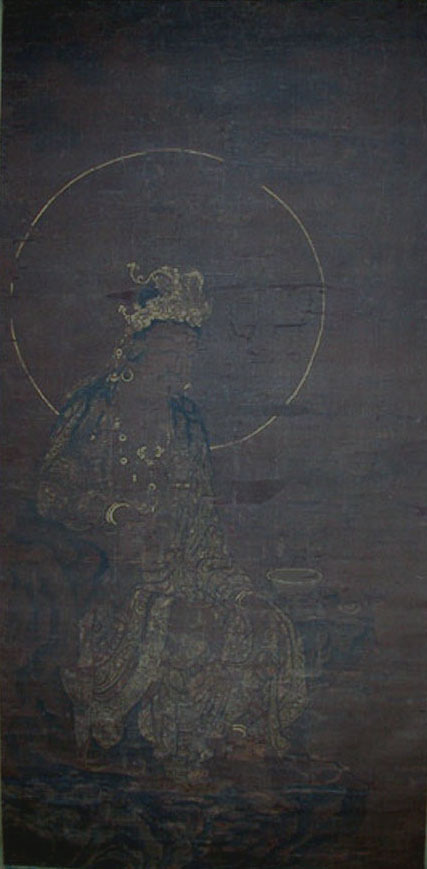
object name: hanging scroll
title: Seated Guanyin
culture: chinese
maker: unidentified artist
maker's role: artist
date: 960-1368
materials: gold, ink, silk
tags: buddhism,bodhisattvas